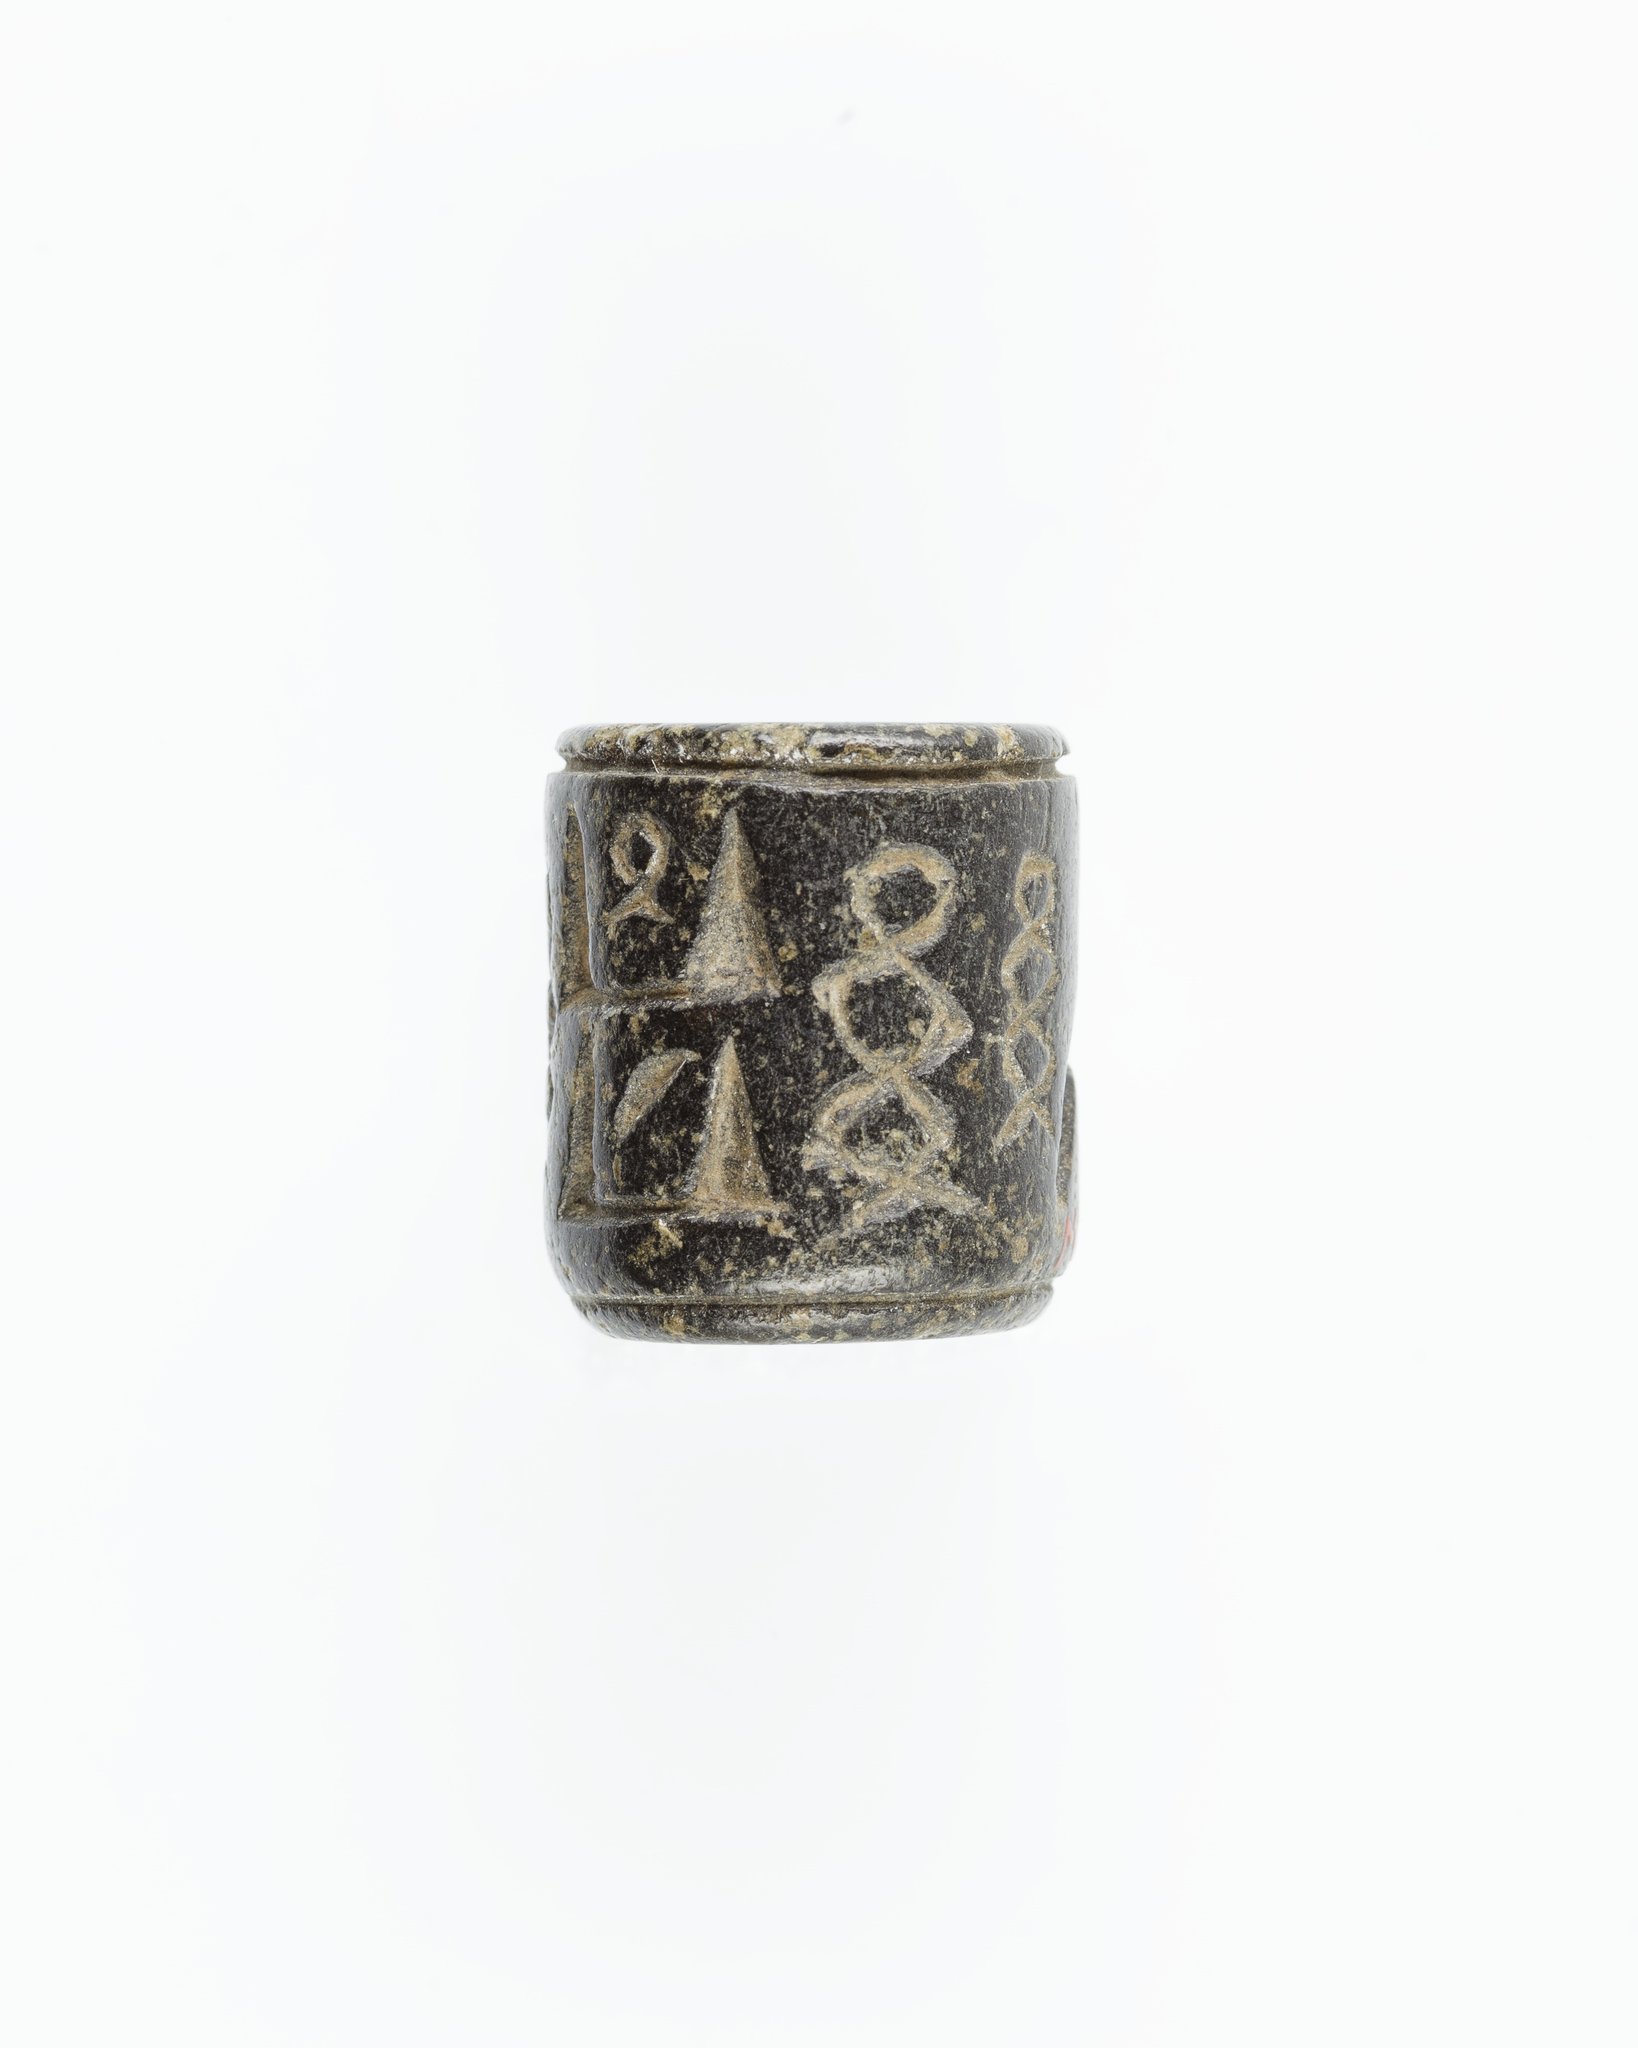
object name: cylinder seal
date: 2960-2649 BCE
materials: stone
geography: egypt